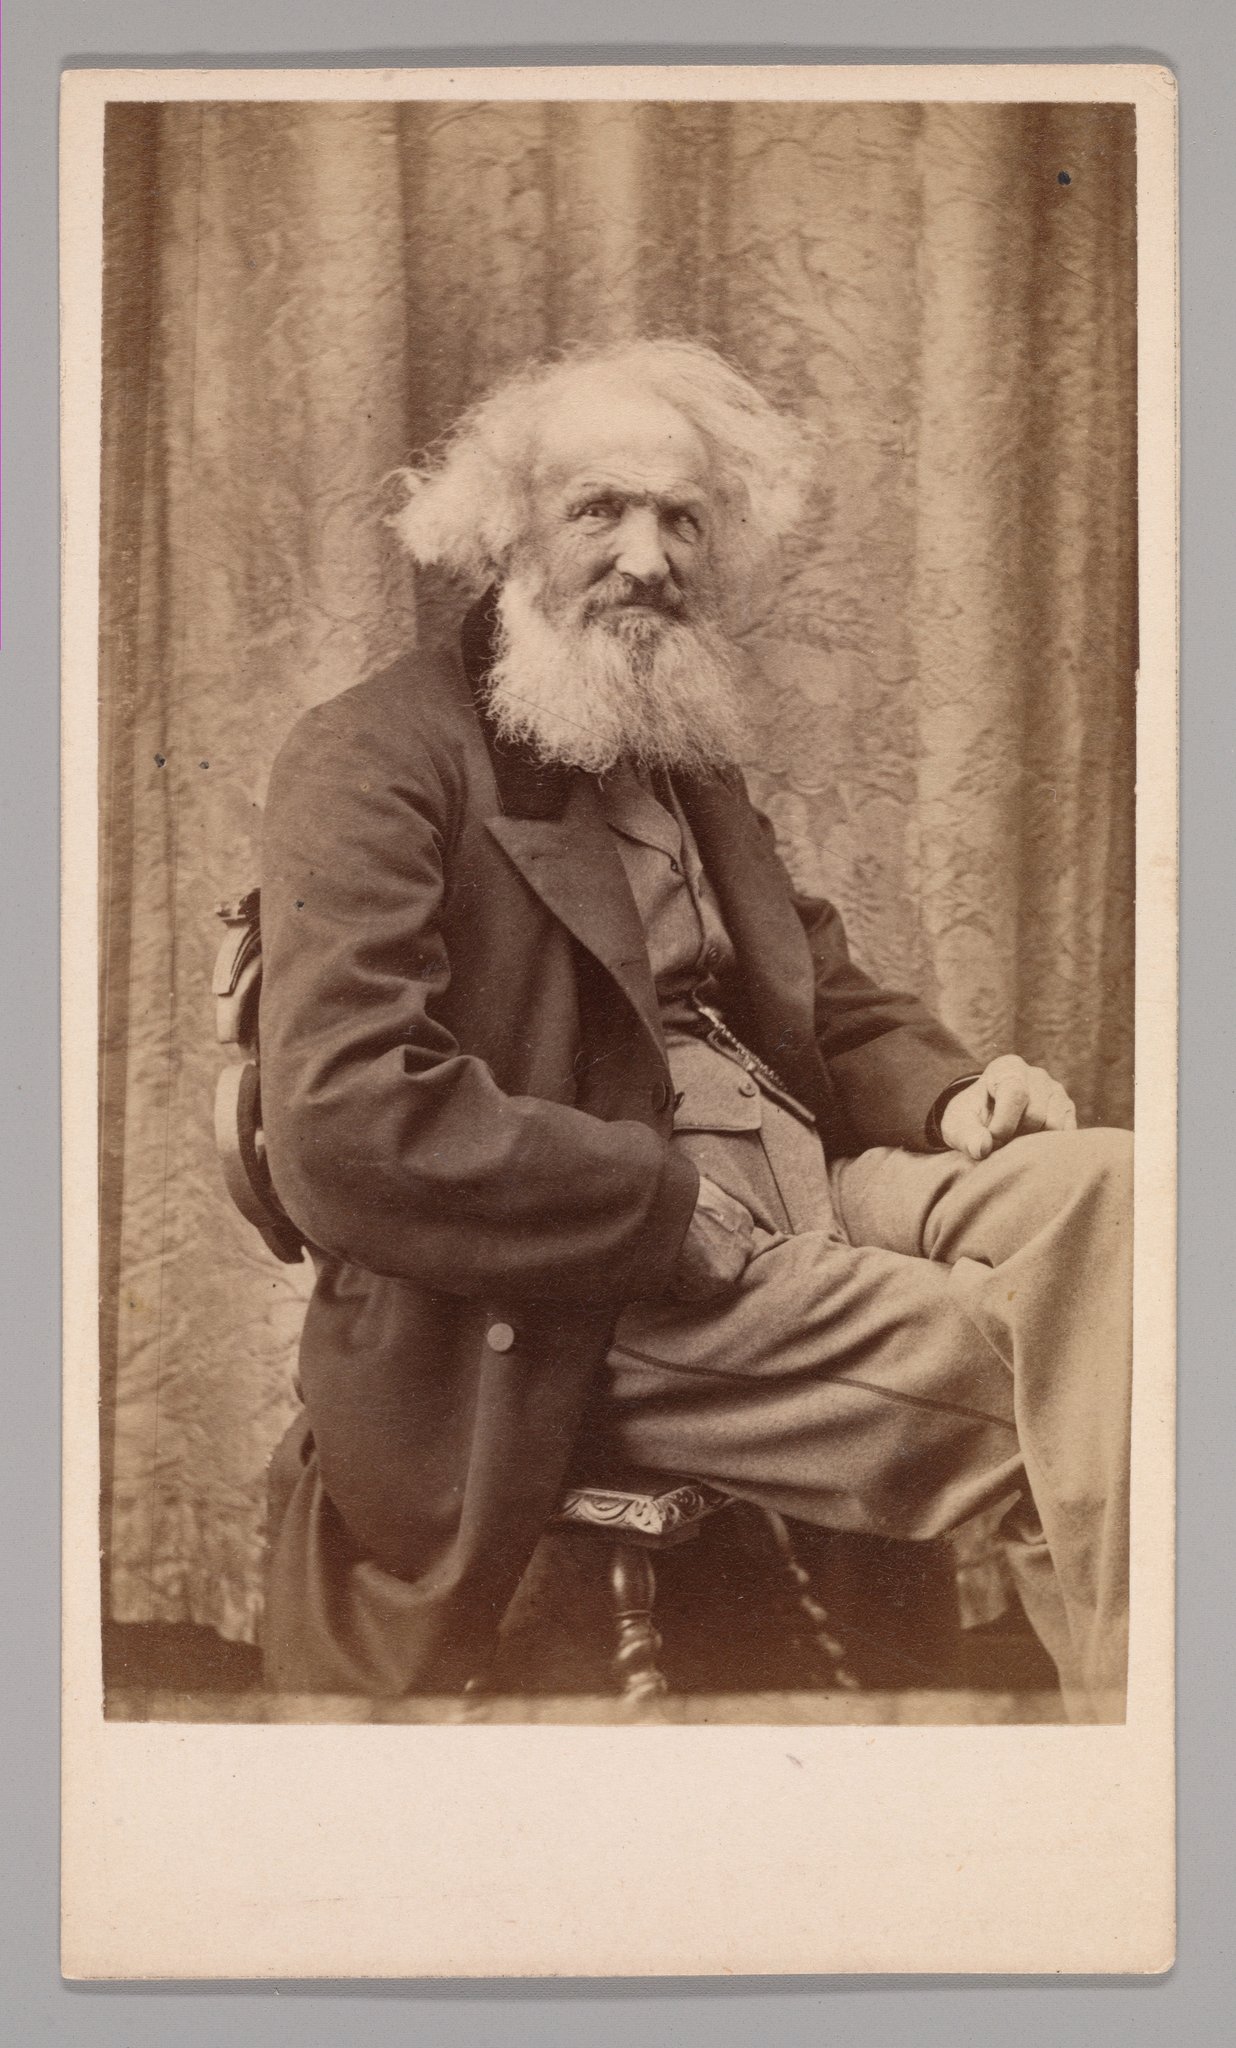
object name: carte de visite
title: [Unknown Subject]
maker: Anonymous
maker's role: artist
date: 1860-1869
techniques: albumen silver print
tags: men,portraits